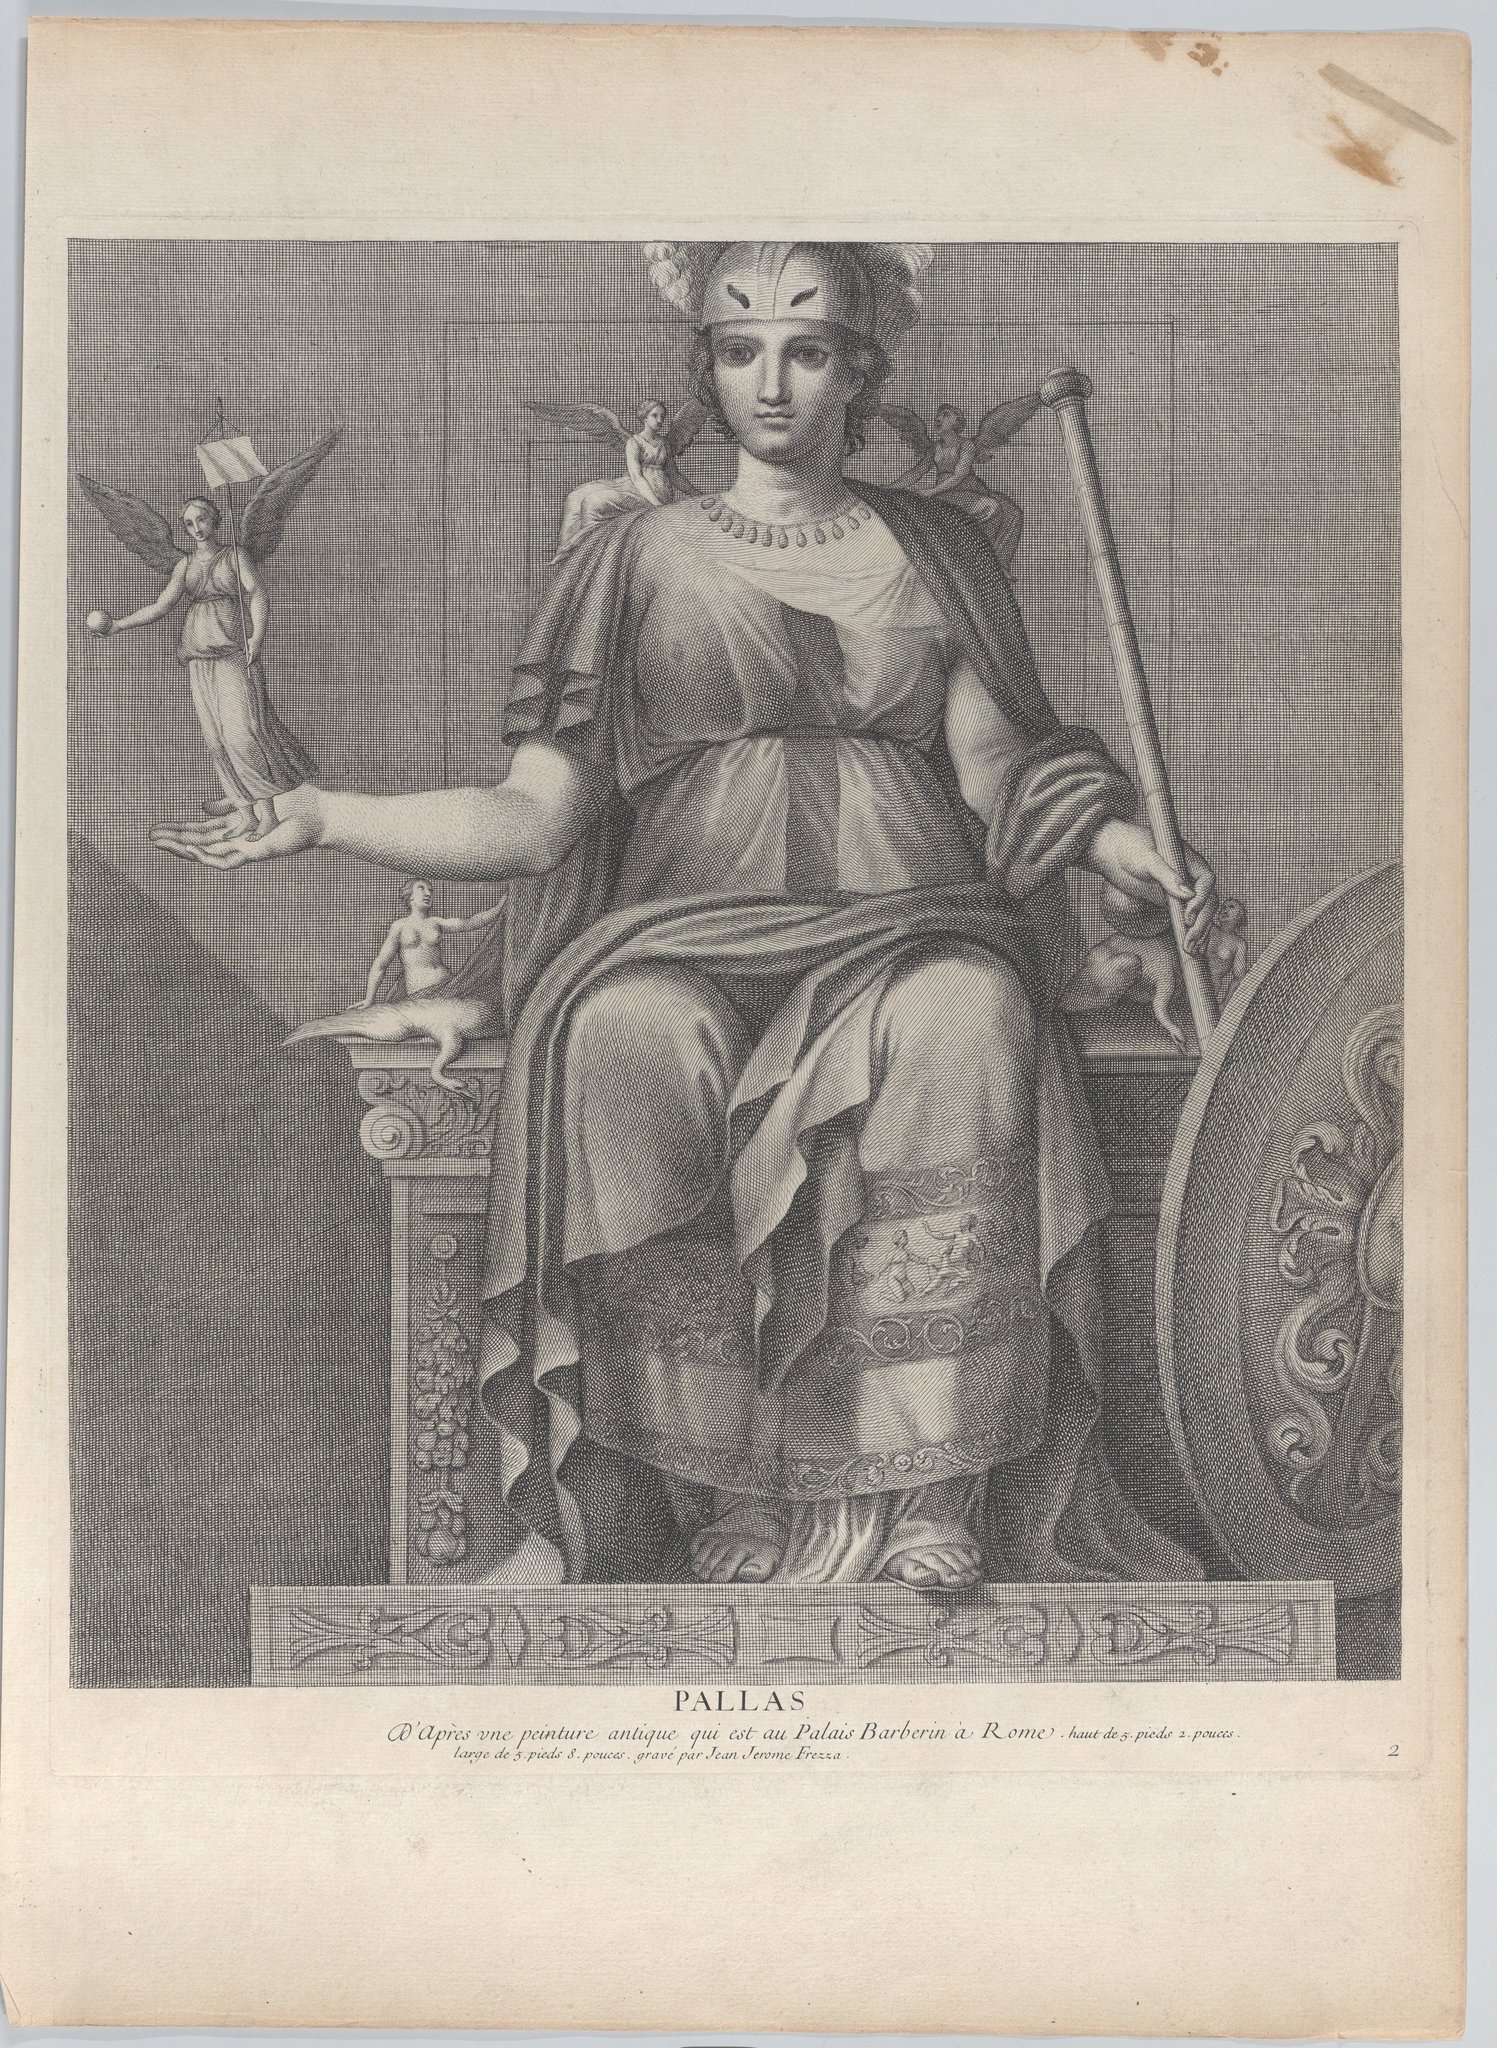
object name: print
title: Pallas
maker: giovanni girolamo frezza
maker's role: artist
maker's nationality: italian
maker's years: 1671-1753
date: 1680-1741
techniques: engraving, etching